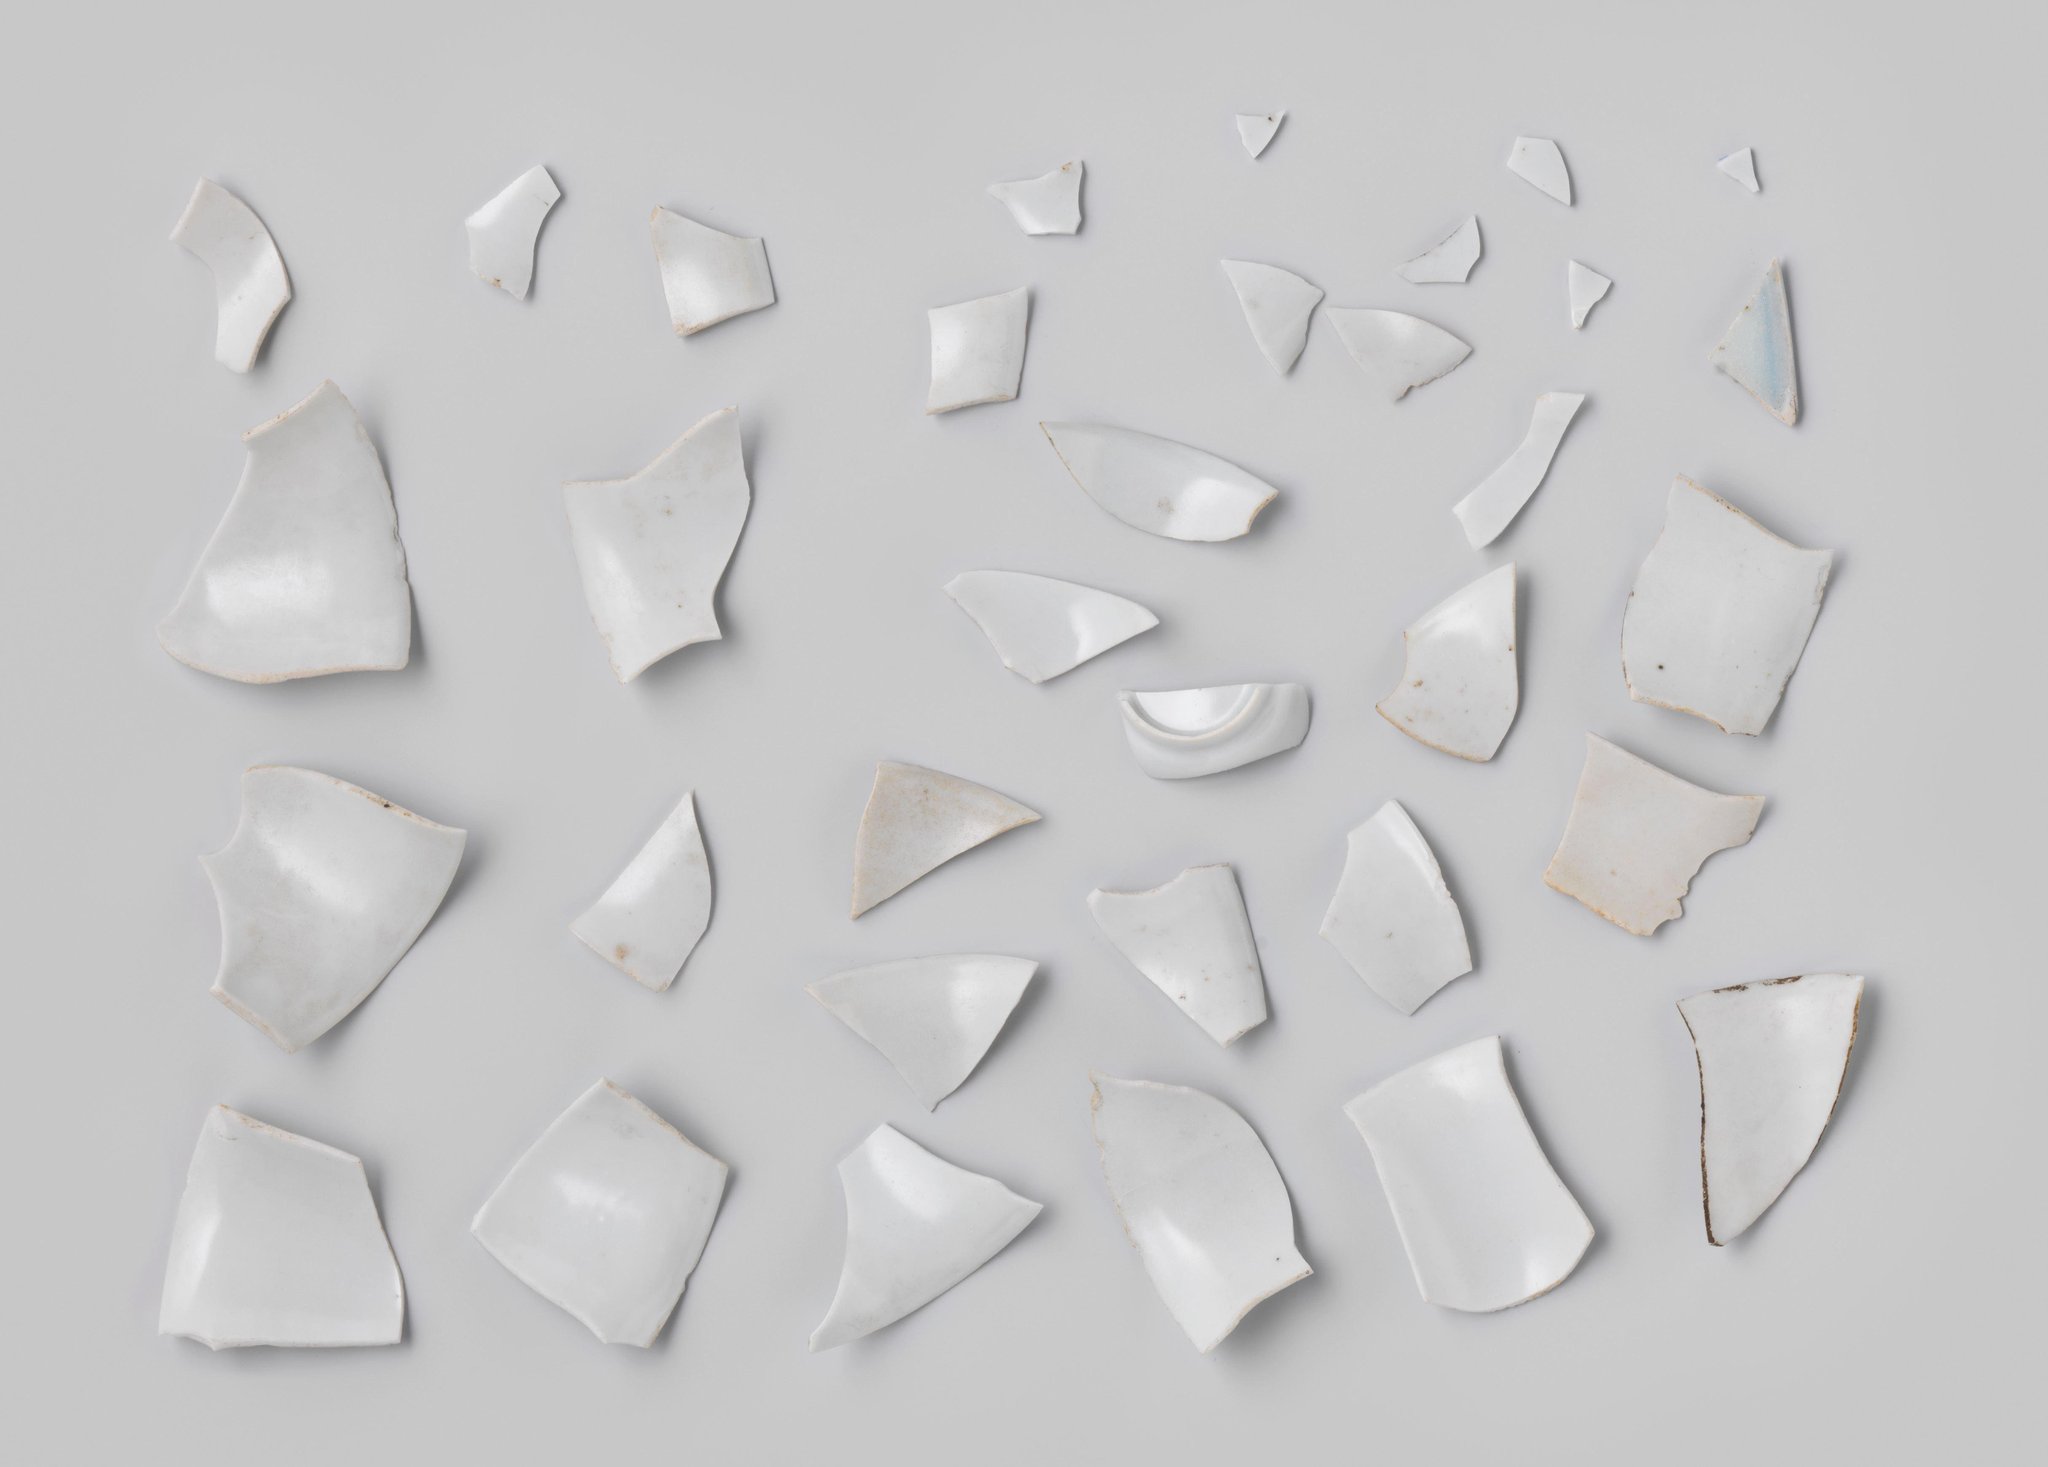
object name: wine cup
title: Scherven van wijnkommen uit V.O.C.-schip de 'Witte Leeuw'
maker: Anonymous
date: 1613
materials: porcelain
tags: verenigde oostindische compagnie, sint-helena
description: Scherven van wijnkommen uit V.O.C.-schip de 'Witte Leeuw'.